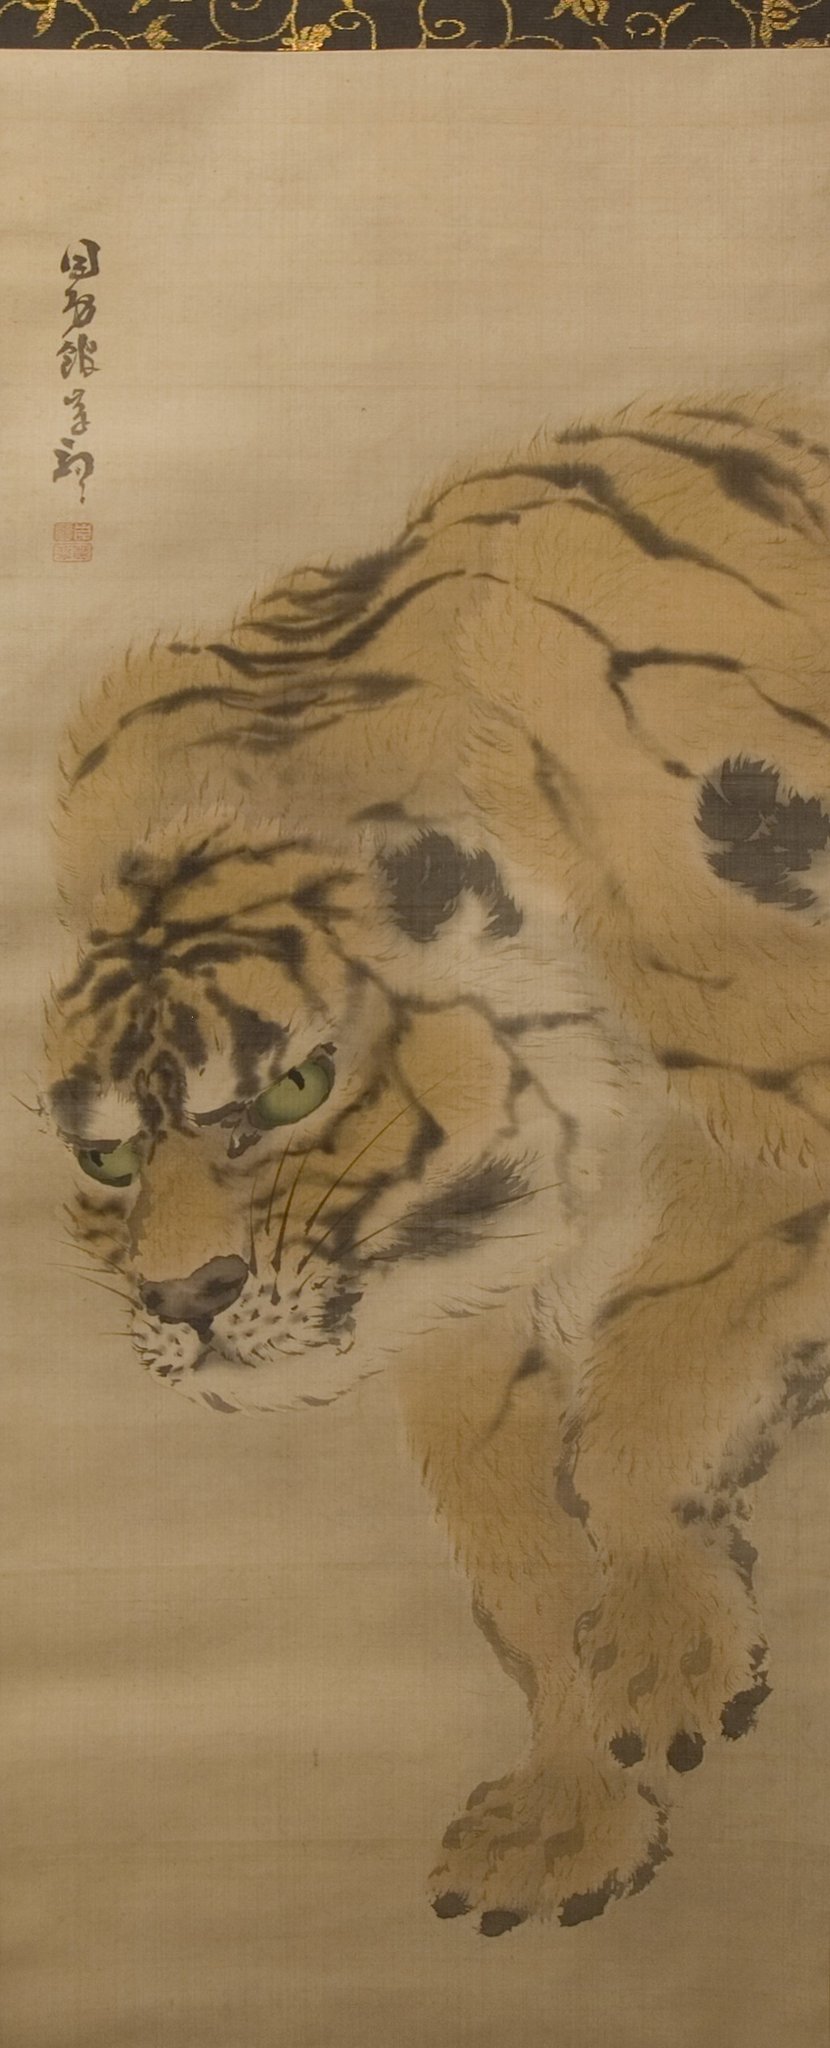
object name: hanging scroll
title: Tiger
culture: japanese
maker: gan ku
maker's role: artist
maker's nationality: japanese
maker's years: 1749-1838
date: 1801-1833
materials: ink, silk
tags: tigers